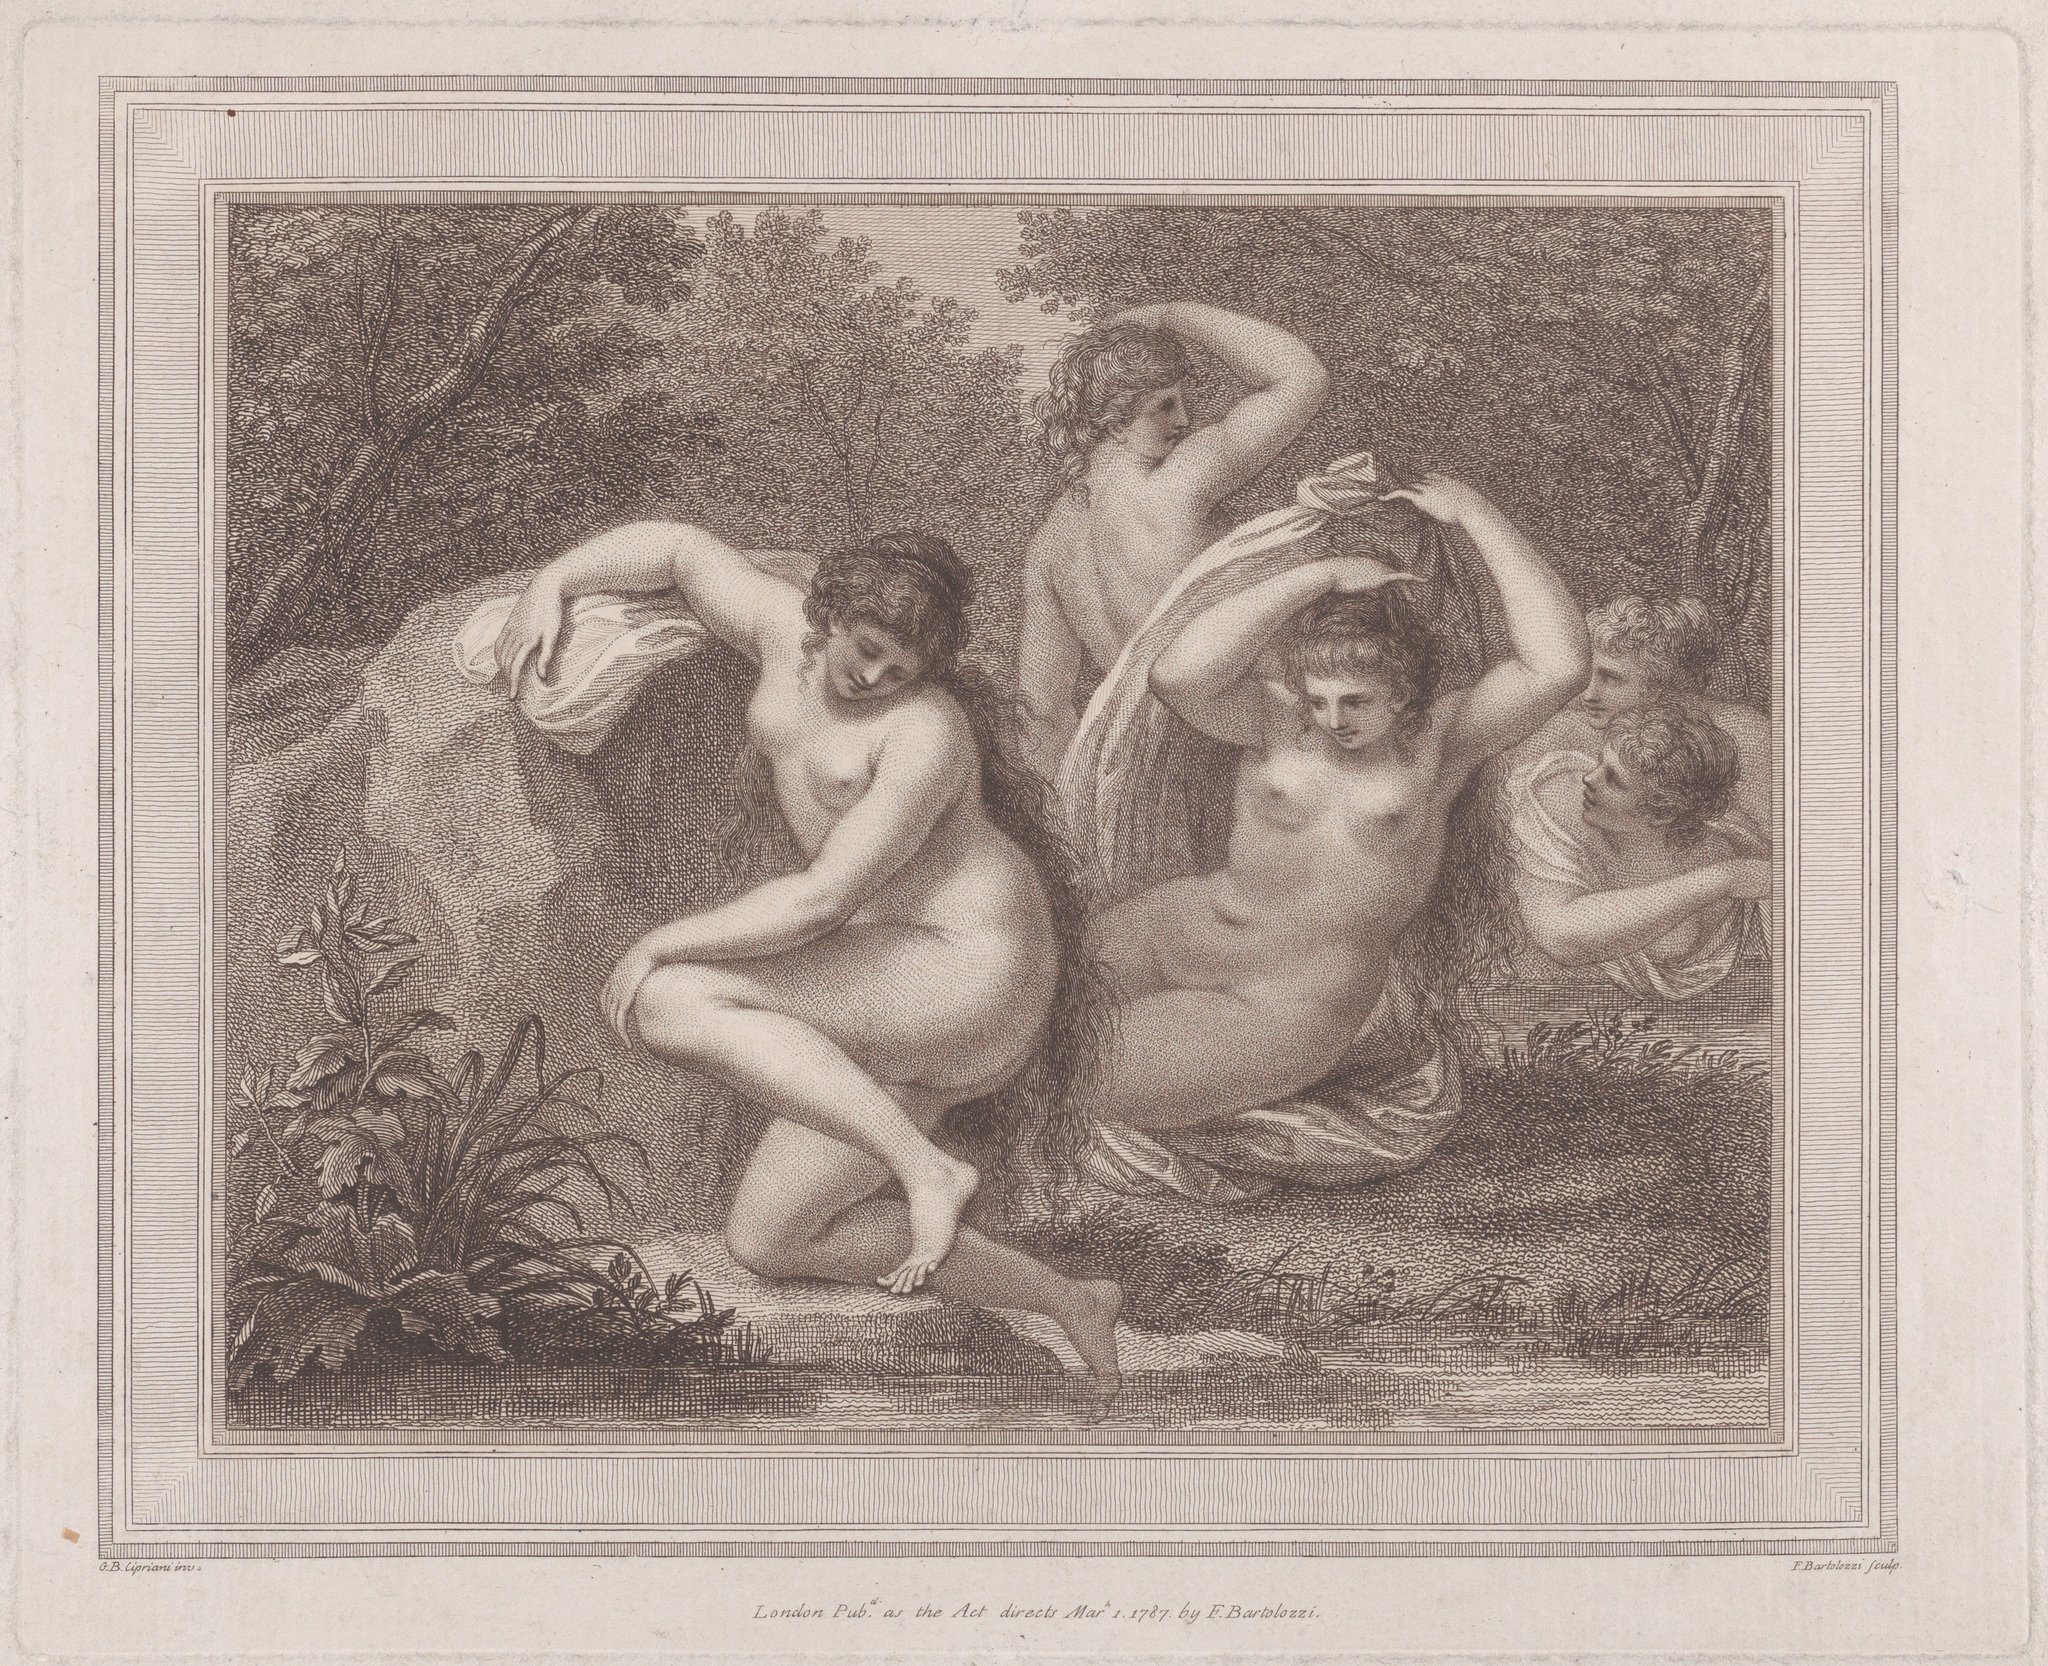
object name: print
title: Bathing Nymphs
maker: francesco bartolozzi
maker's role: artist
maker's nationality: italian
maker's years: 1728-1815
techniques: etching